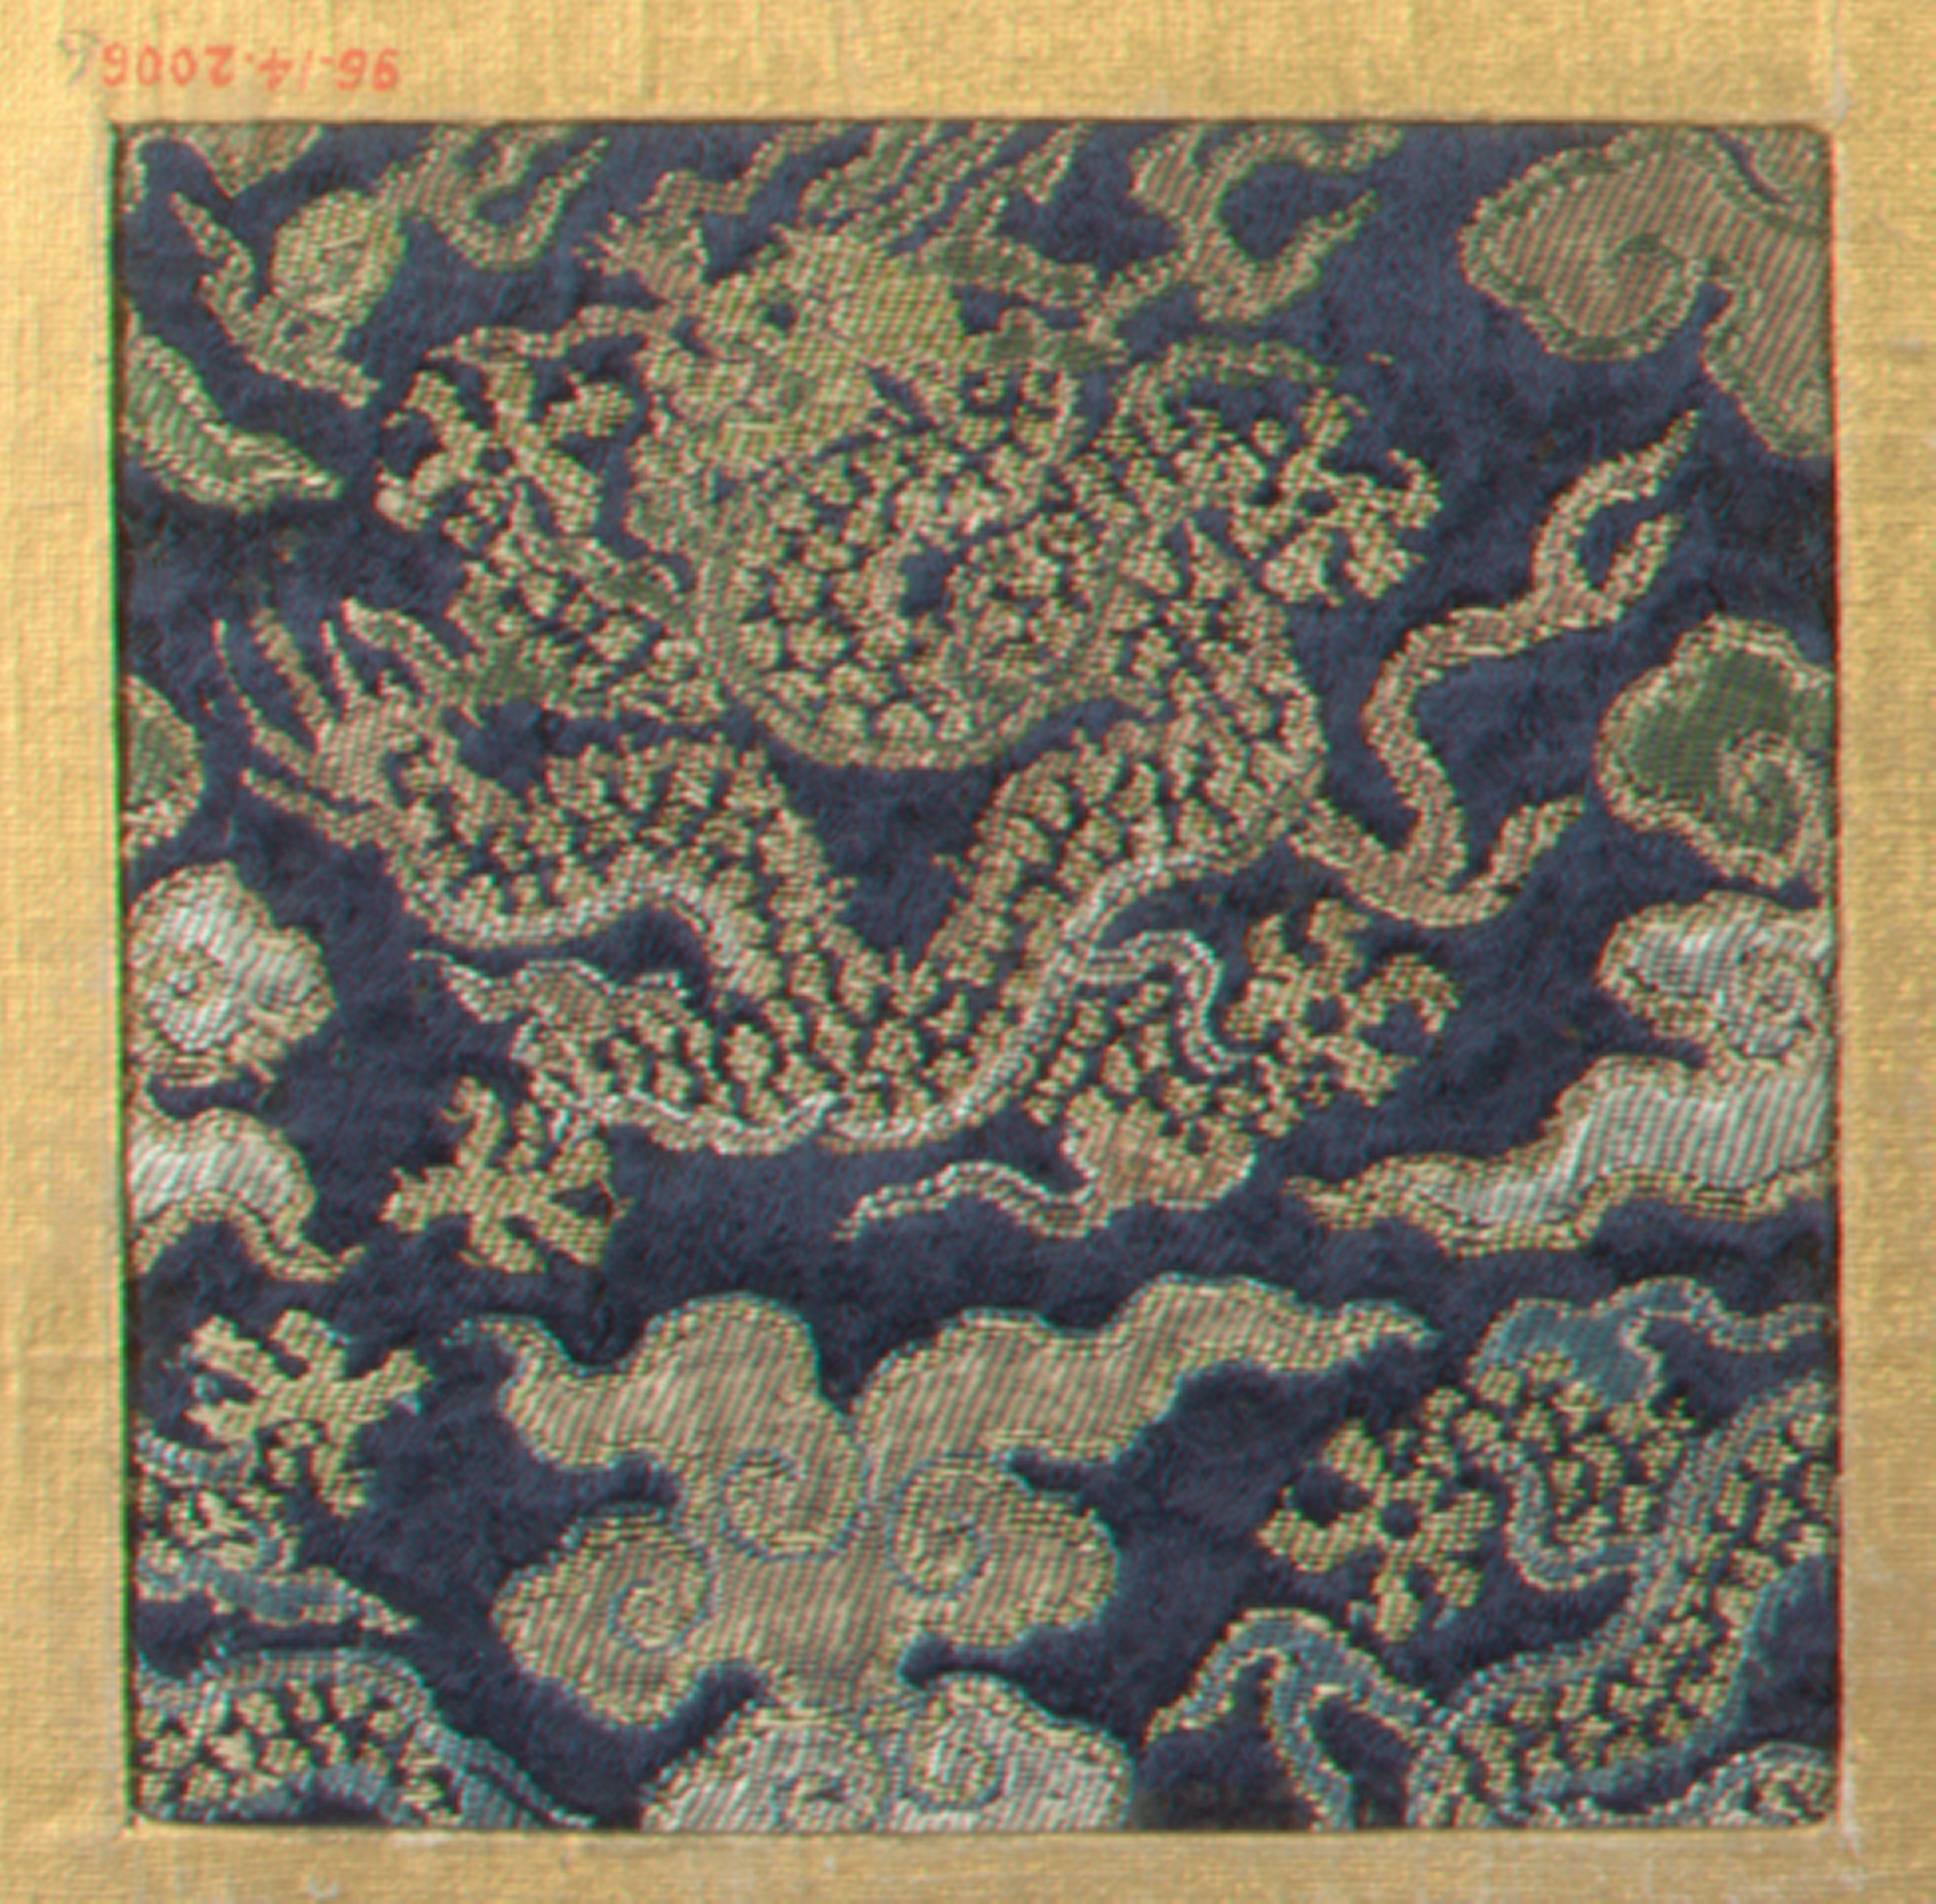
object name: piece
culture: japanese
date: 1701-1900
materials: silk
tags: dragons